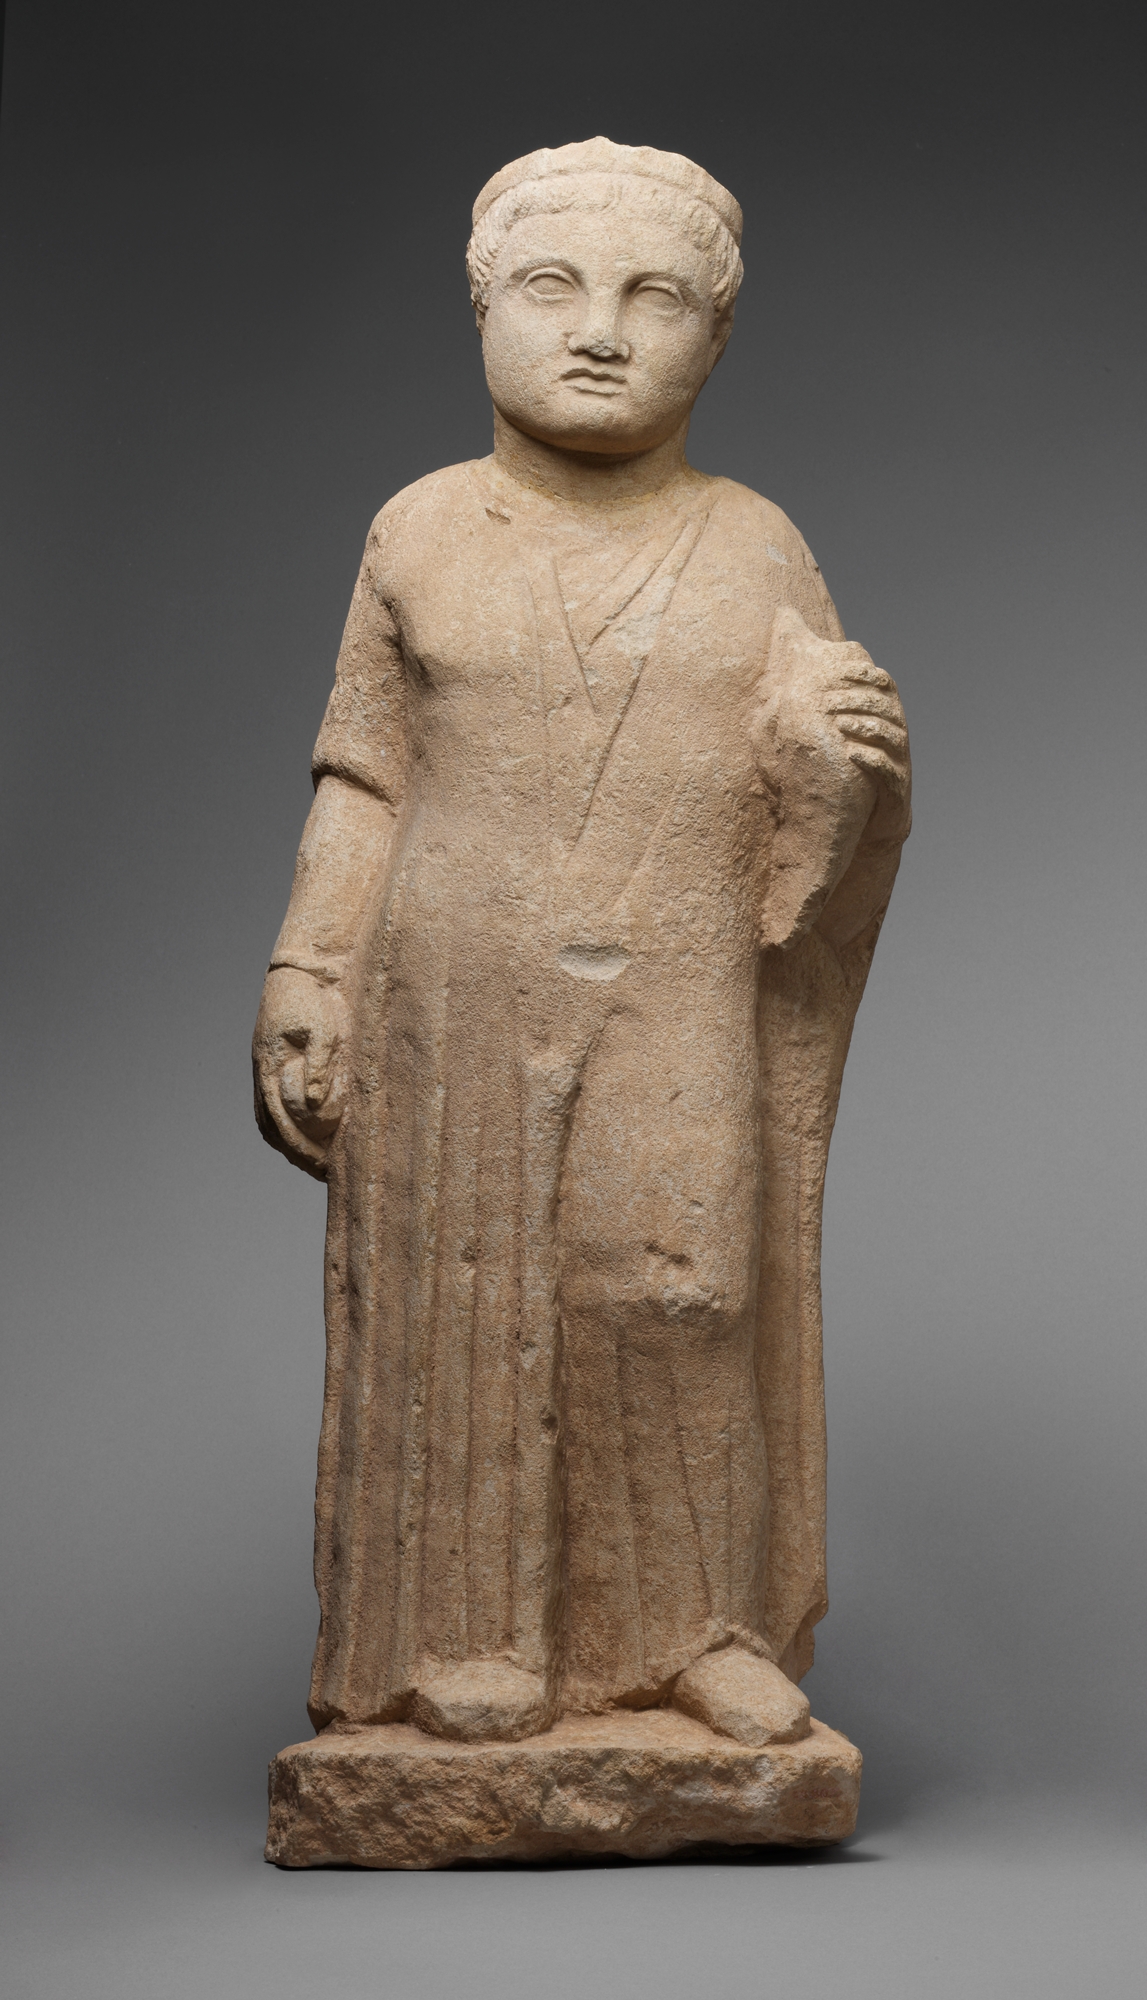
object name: statue of a male votary holding a dove and an apple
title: Limestone statue of a male votary holding a dove and an apple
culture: cypriot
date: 300-1 BCE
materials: limestone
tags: doves,apples,men